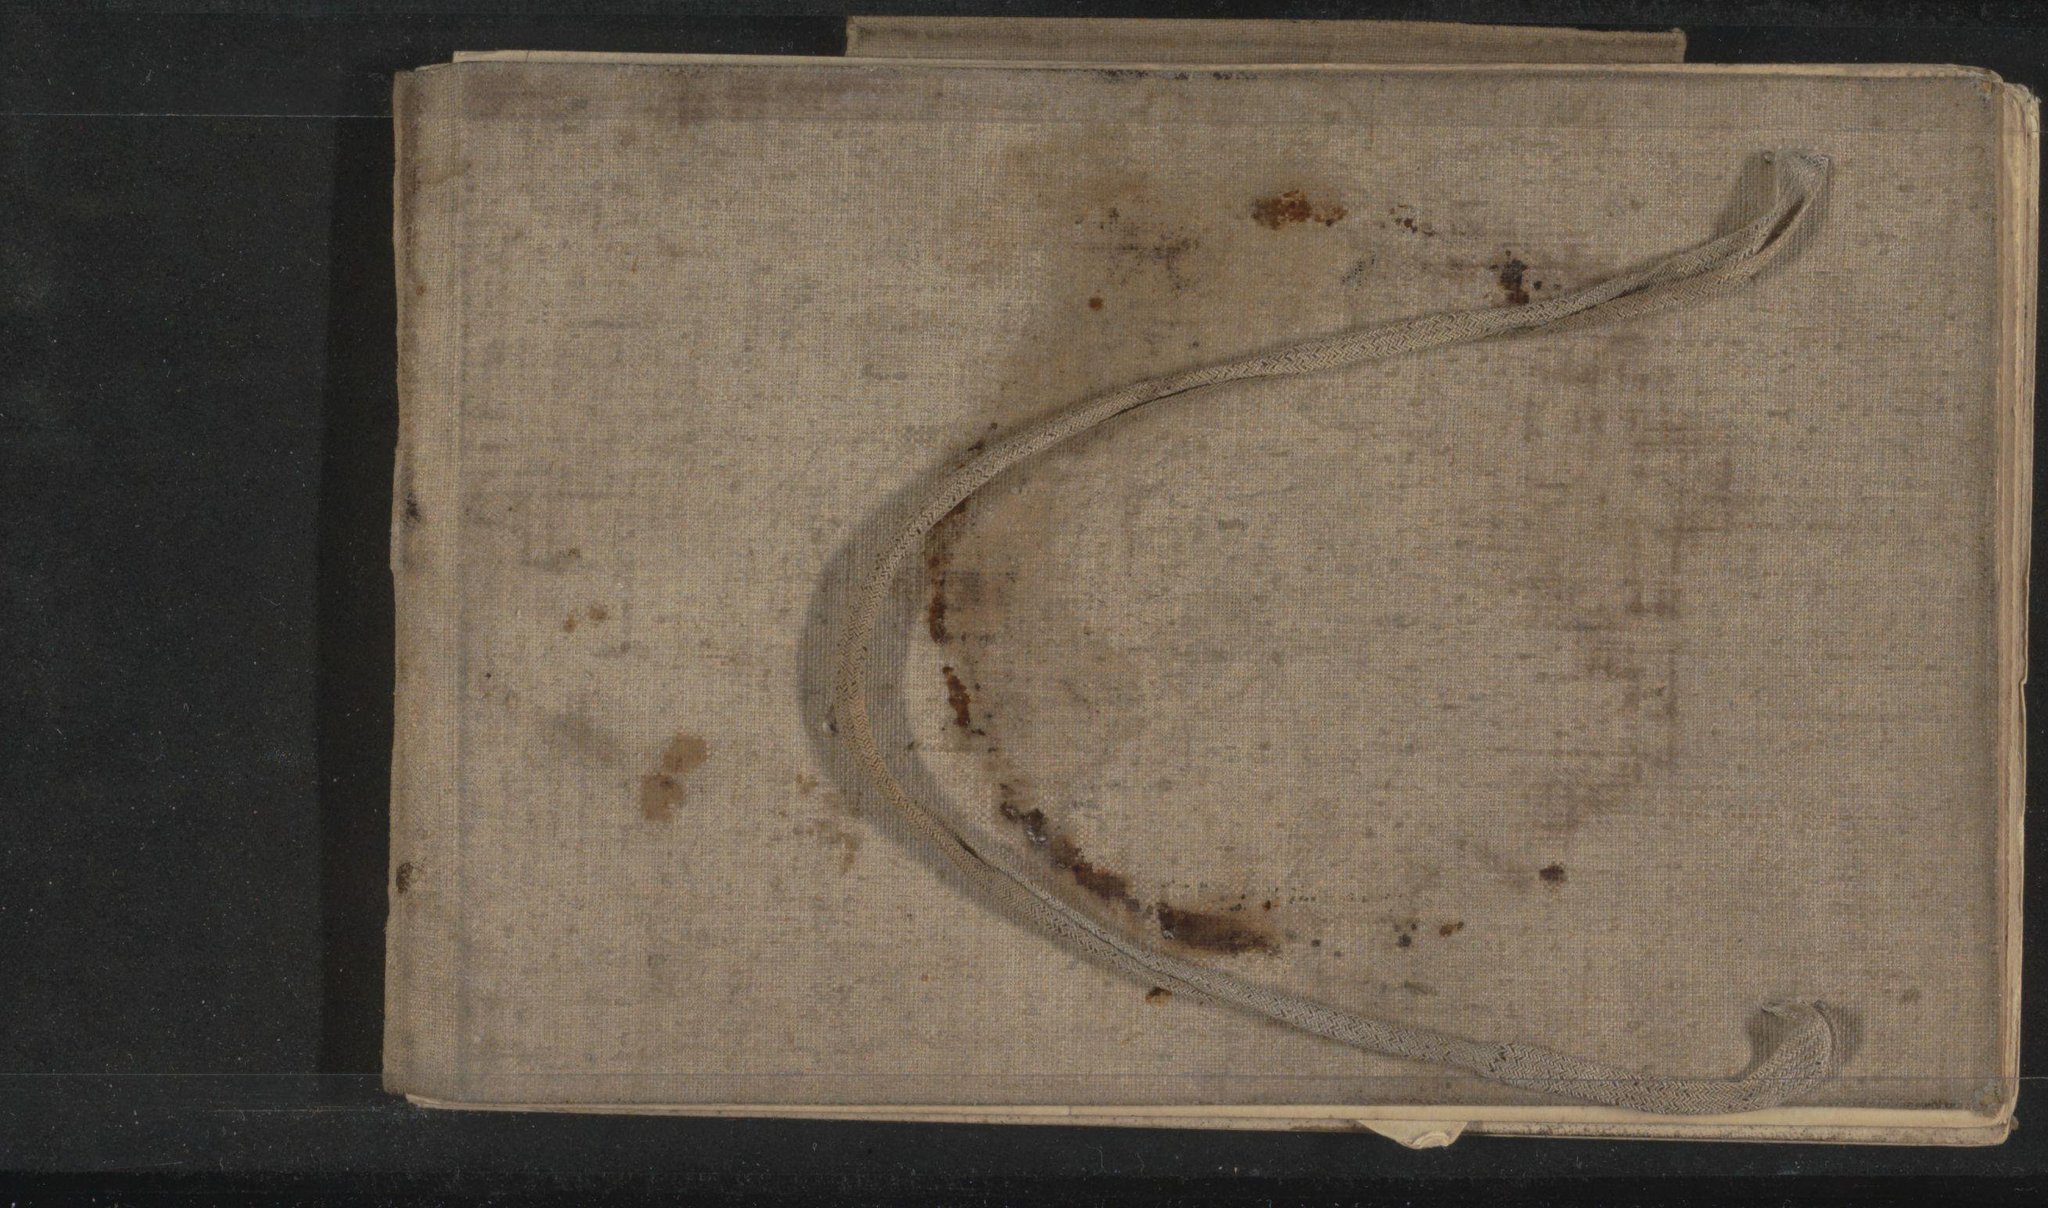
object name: sketchbook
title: Schetsboek met 19 bladen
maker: willem witsen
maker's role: draughtsman, painter, print maker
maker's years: 1860-1923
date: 1888-1891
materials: cardboard, chalk, linen, paper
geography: london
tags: square, place, circus, etc., adult woman, civic architecture; edifices; dwellings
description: Pagina 6 t/m pagina 15 en pagina 24 t/m pagina 33 bevatten geen voorstelling.